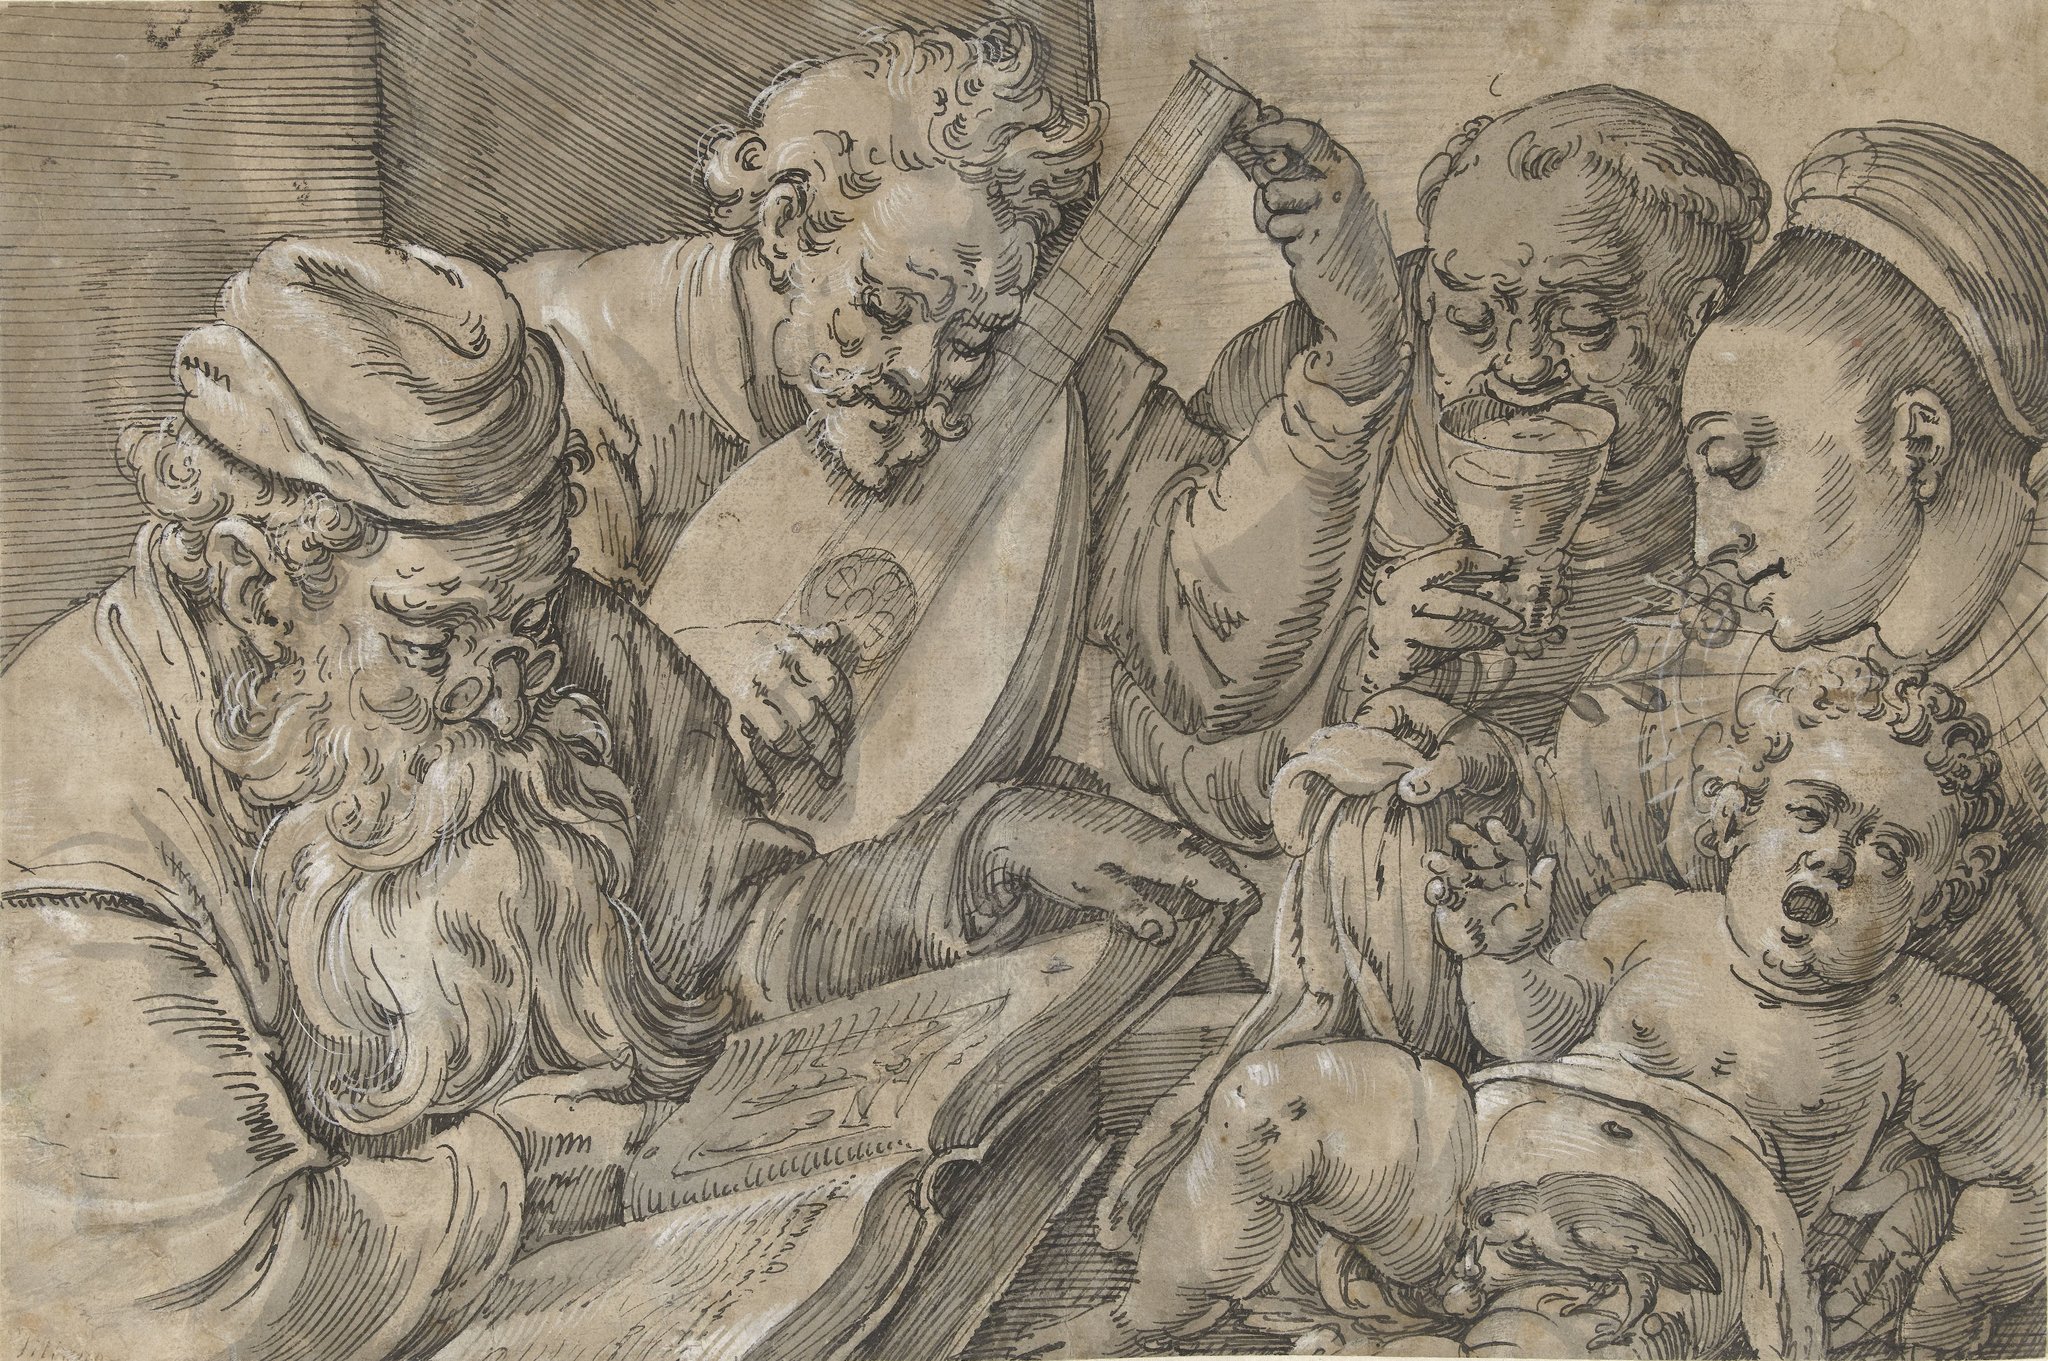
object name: drawing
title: De vijf zintuigen (en tevens vijf leeftijden?)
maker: anton möller (der ältere)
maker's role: draughtsman, print maker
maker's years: 1563-1611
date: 1578-1611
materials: ink, paper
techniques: brush, pen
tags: reading, the (five) senses, the ages of man, glass of wine, mother and baby or young child, lute, and special forms of lute, e.g.: theorbo